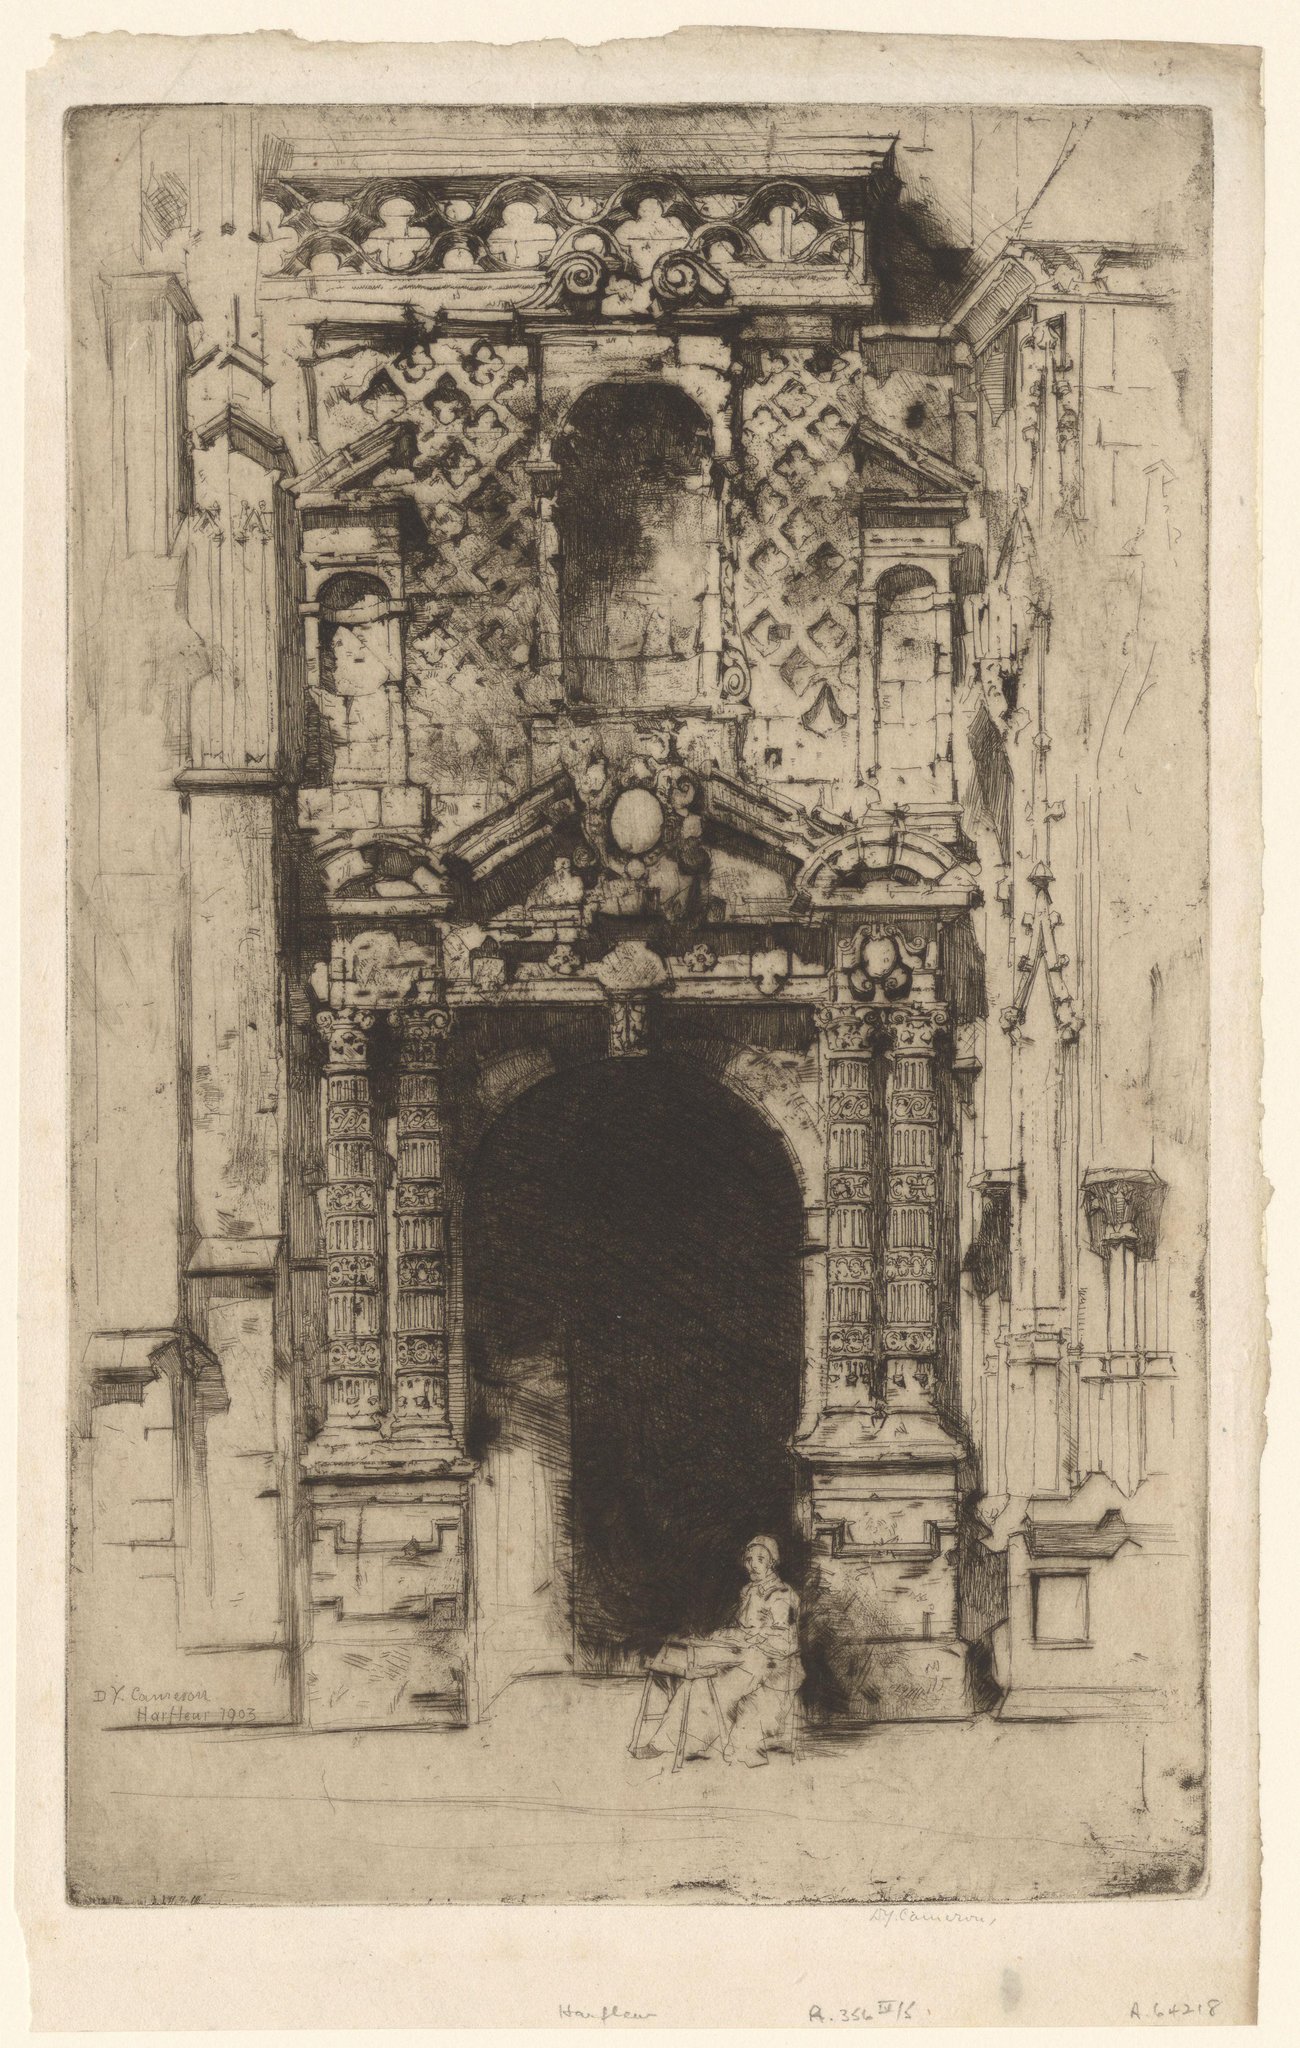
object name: print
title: Harfleur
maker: david young cameron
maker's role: draughtsman, print maker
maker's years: 1865-1945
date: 1903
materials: paper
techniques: drypoint, etching, intaglio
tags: church (exterior), gate, entrance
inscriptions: collector's mark: Lugt 2228, collector's mark: Lugt 2760